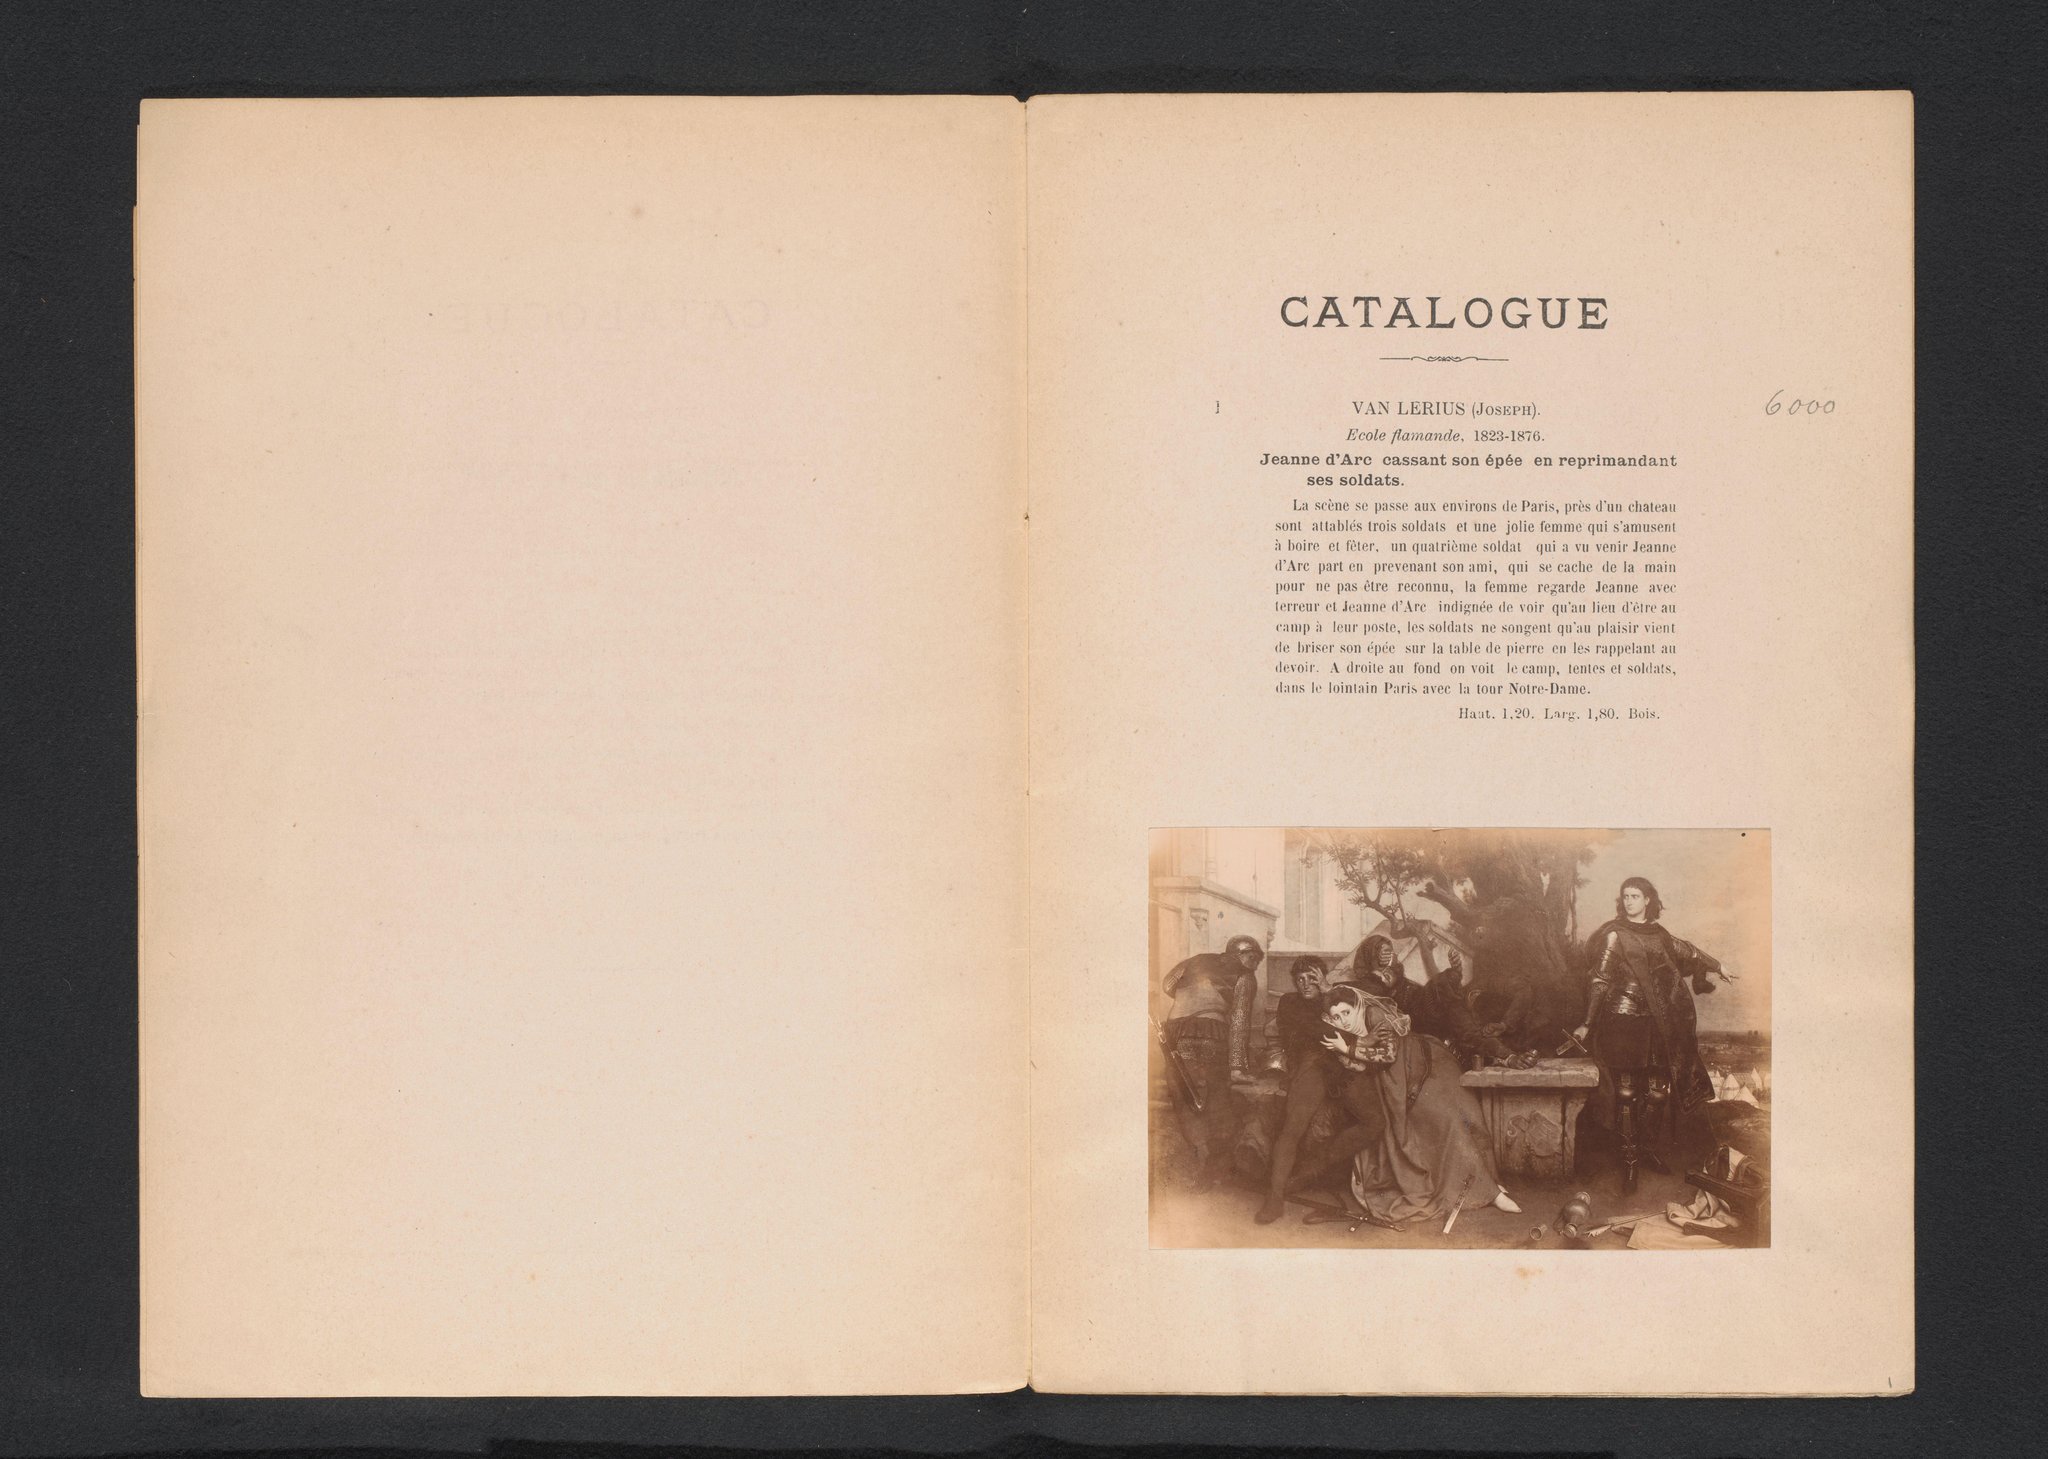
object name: reproduction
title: Fotoreproductie van een schilderij van Jeanne d'Arc die haar soldaten berispt door Jozef van Lerius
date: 1886-1891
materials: photographic support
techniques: gelatin silver print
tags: the company, the unit, the troop ~ military service, joan of arc (jeanne d'arc); possible attributes: armour, banner, lance, sword